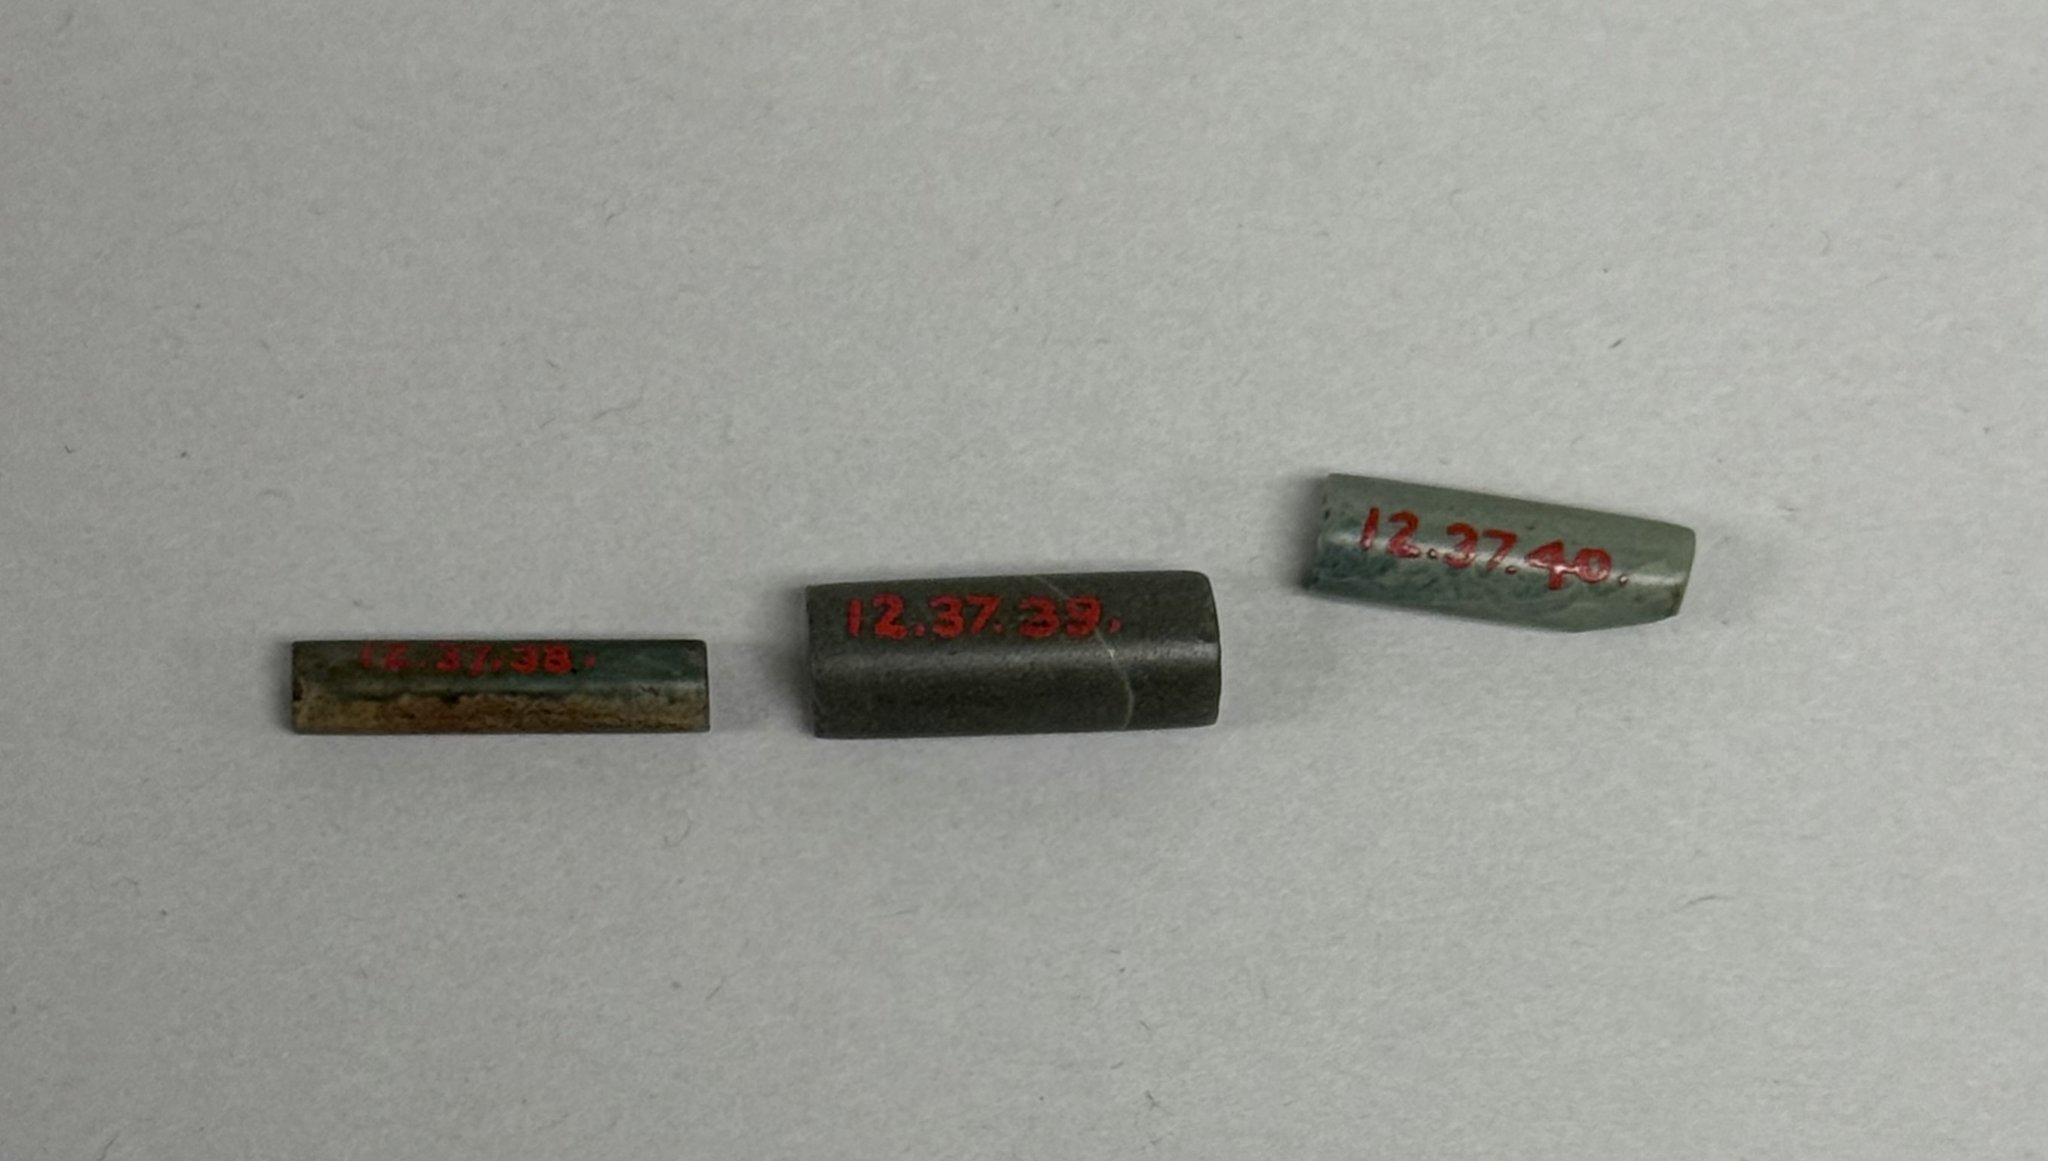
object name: cylinder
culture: japanese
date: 601-700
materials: jasper